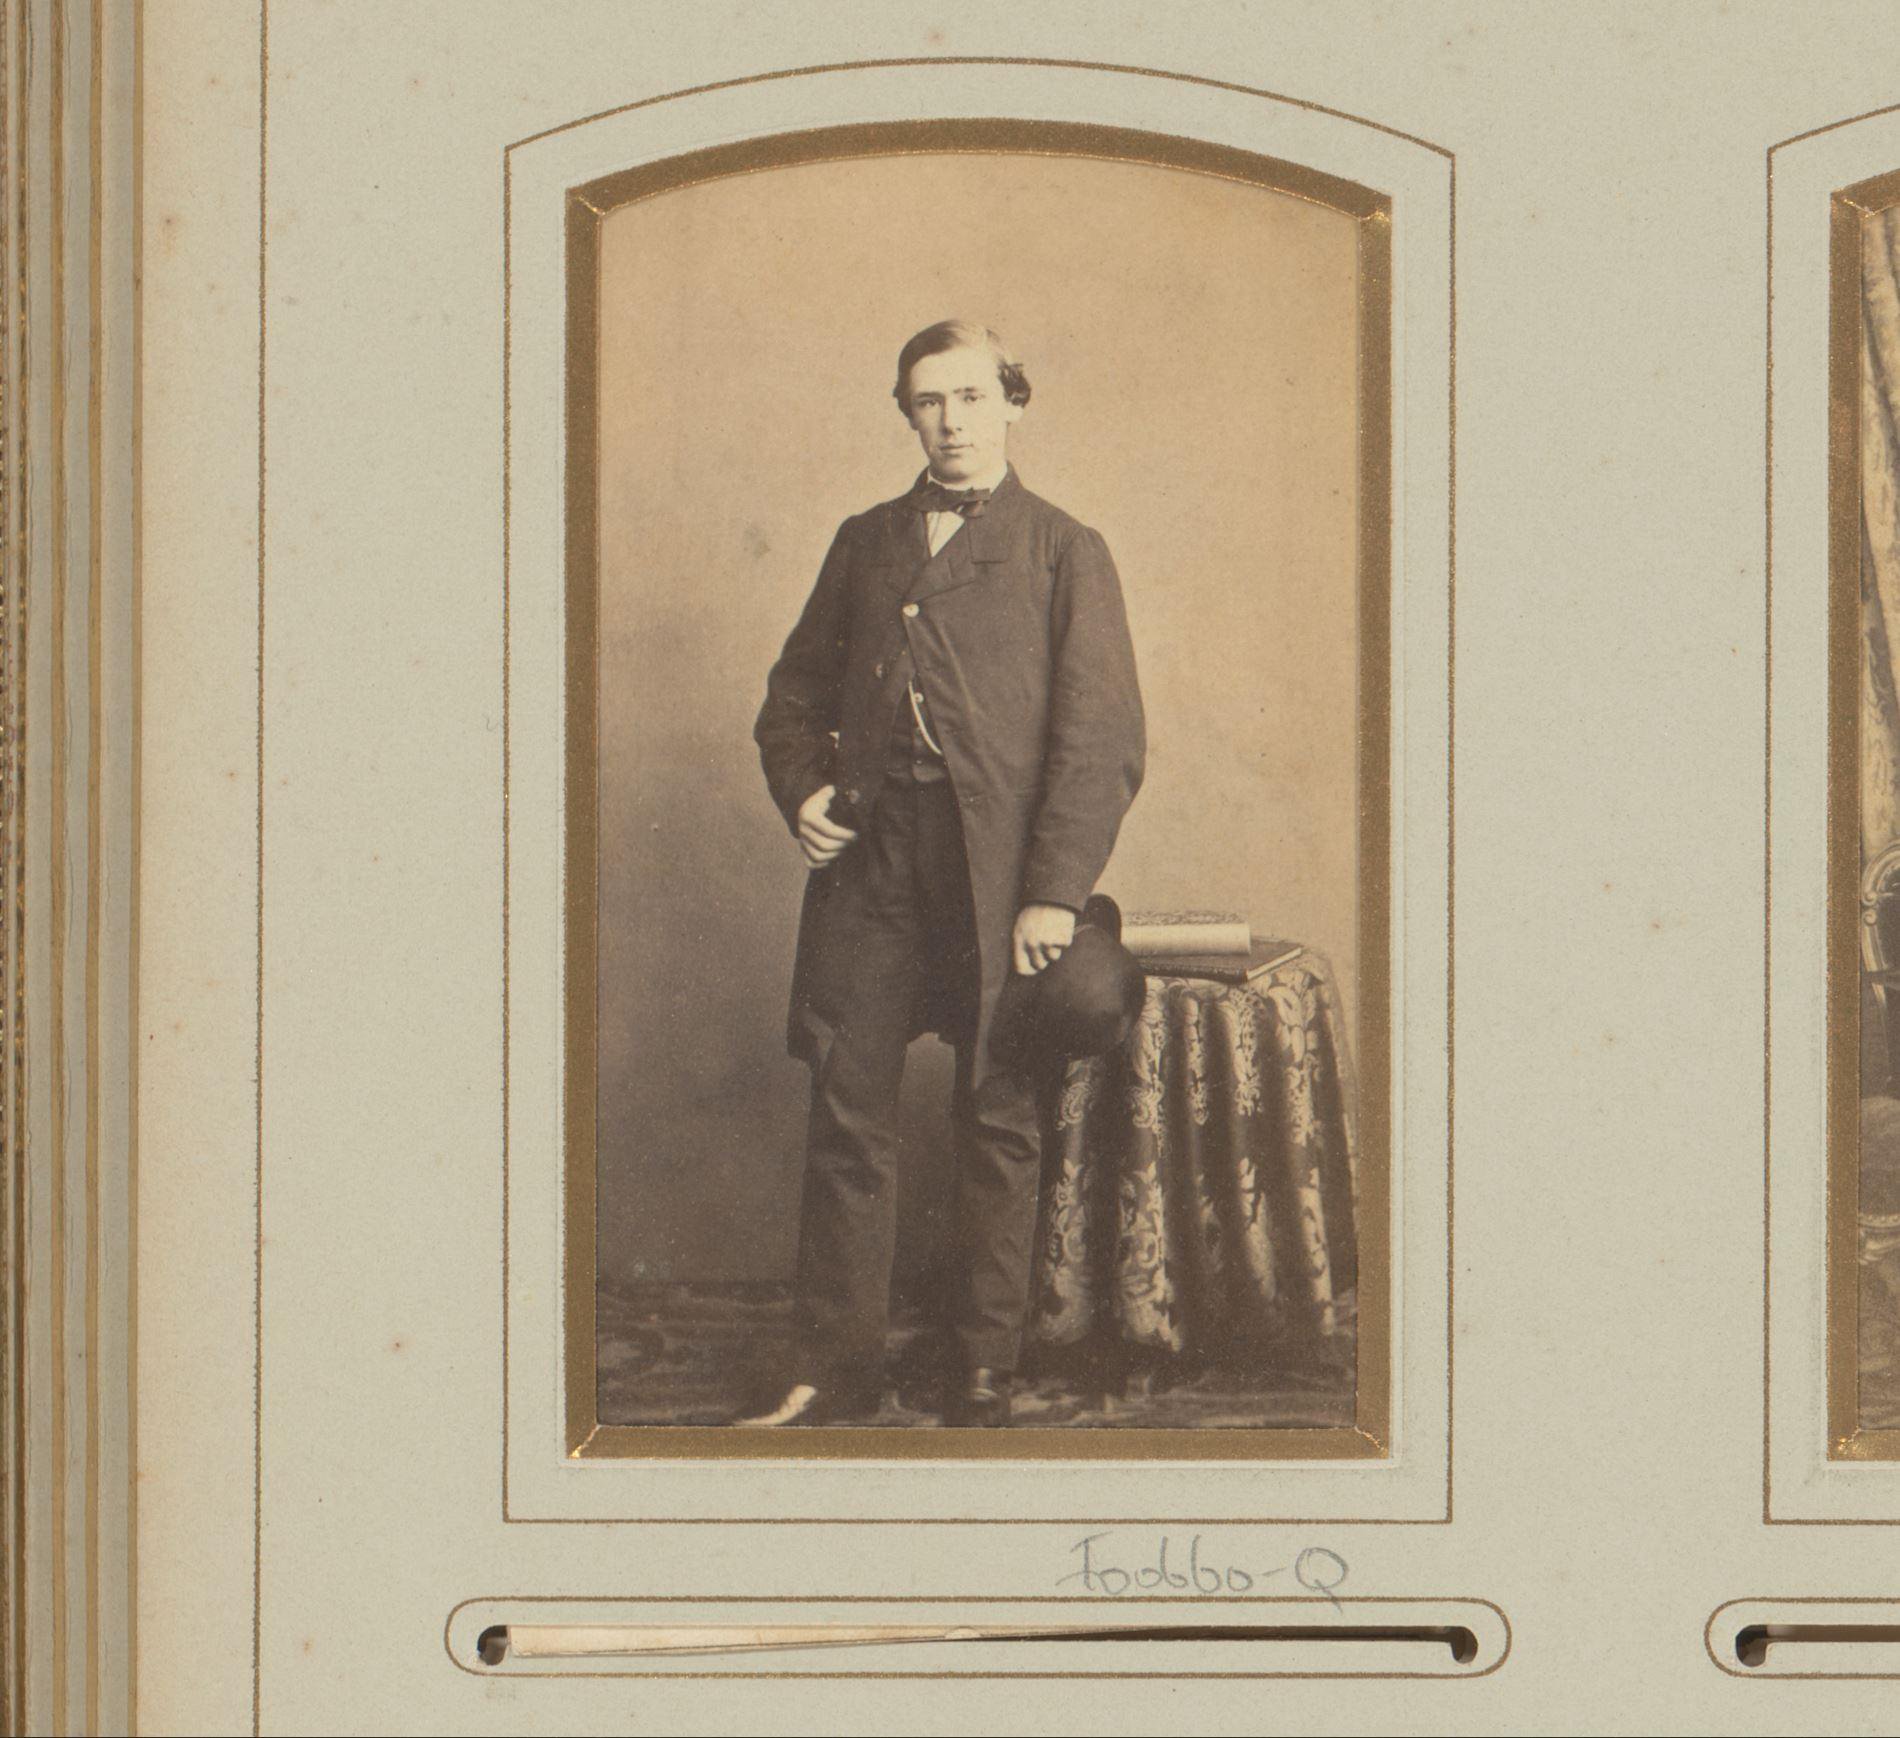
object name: carte de visite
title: Portret van een staande man met hoed in de hand, voor een tafel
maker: joseph dupont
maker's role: fotograaf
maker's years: 1818-1901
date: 1853-1880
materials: cardboard, photographic support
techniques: albumen print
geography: antwerp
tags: historical persons, table, head-gear: hat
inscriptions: inscription: ‘Etablissement Photographique/ de / J. DUPONT,/ Place de Meir, 32/ ANVERS./ Maison fondée en 1853.’